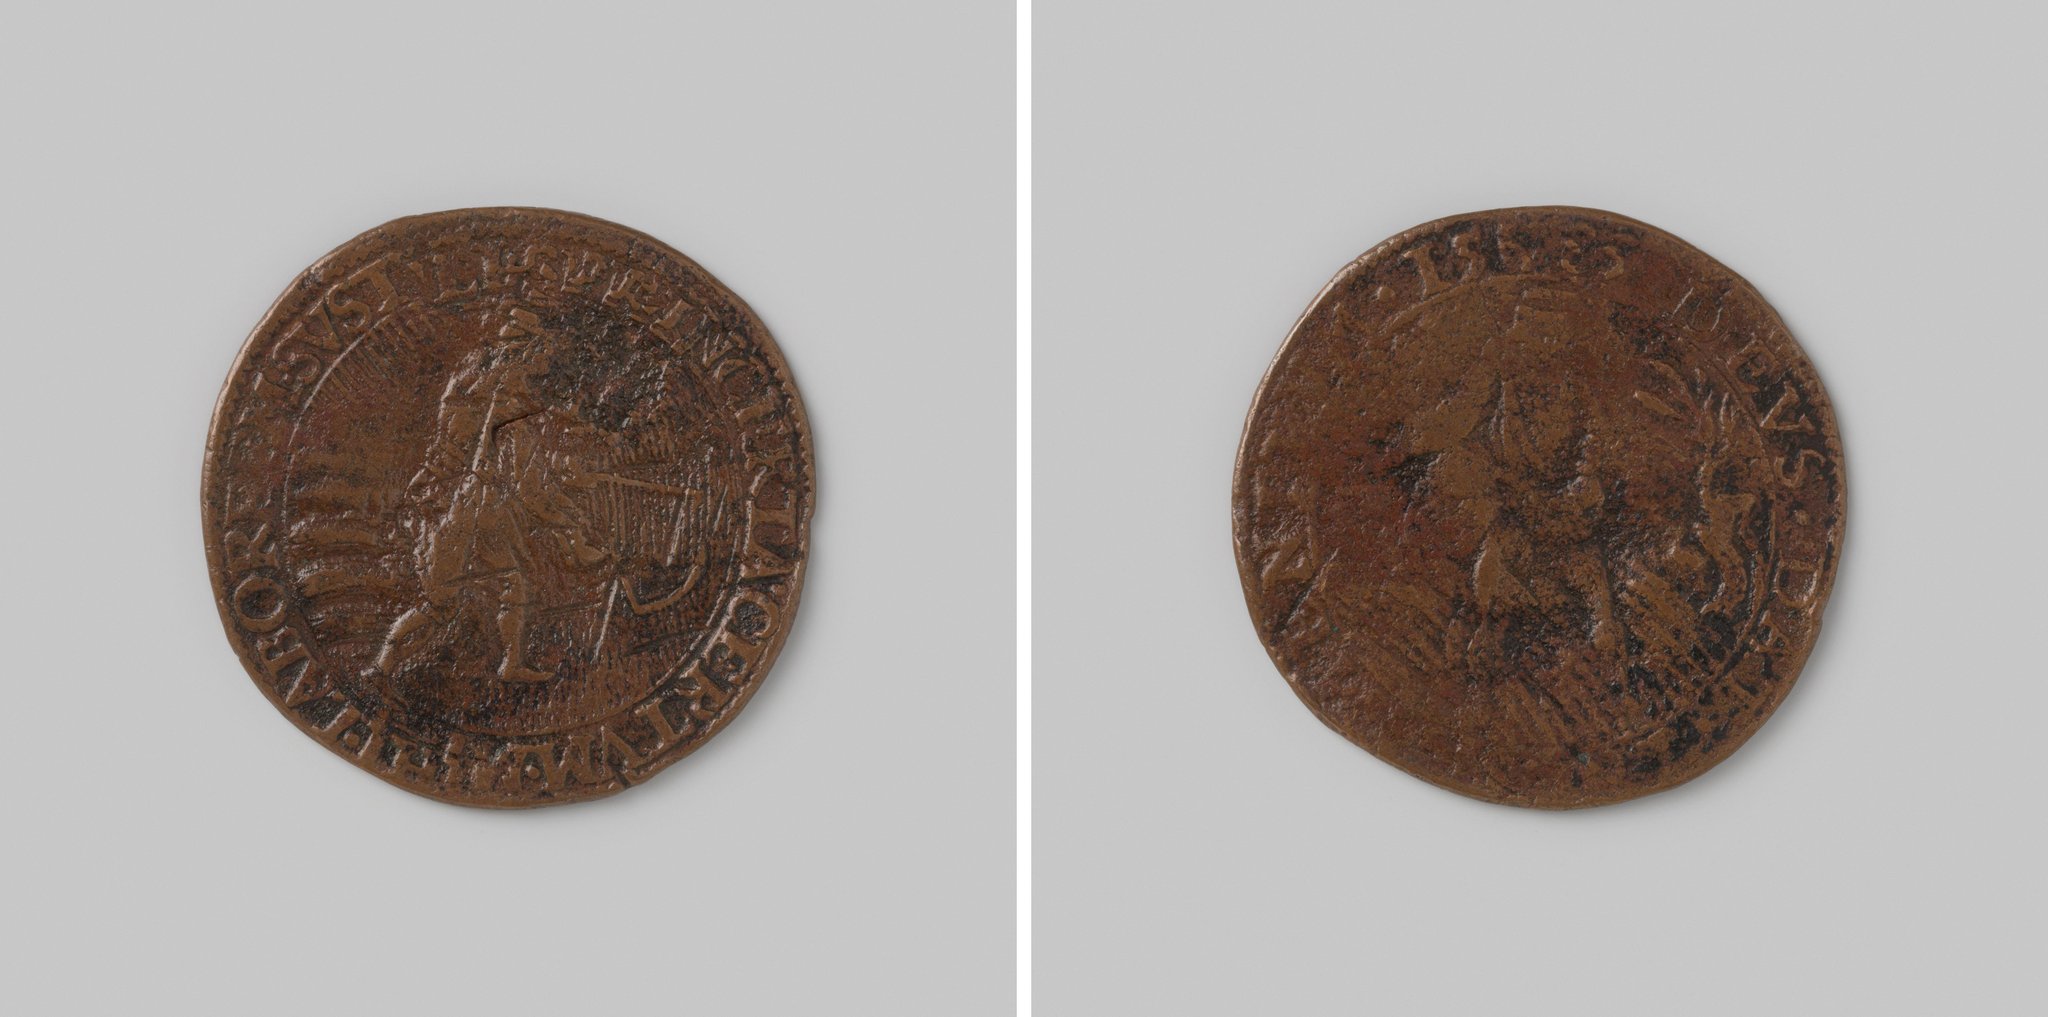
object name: jeton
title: Rekenpenning uit Utrecht op de benoeming van Prins Maurits tot stadhouder 1589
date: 1589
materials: copper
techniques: striking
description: Koperen penning, op de voorzijde een zaaiende boer met omschrift, op de keerzijde een oogstende boer met omschrift.